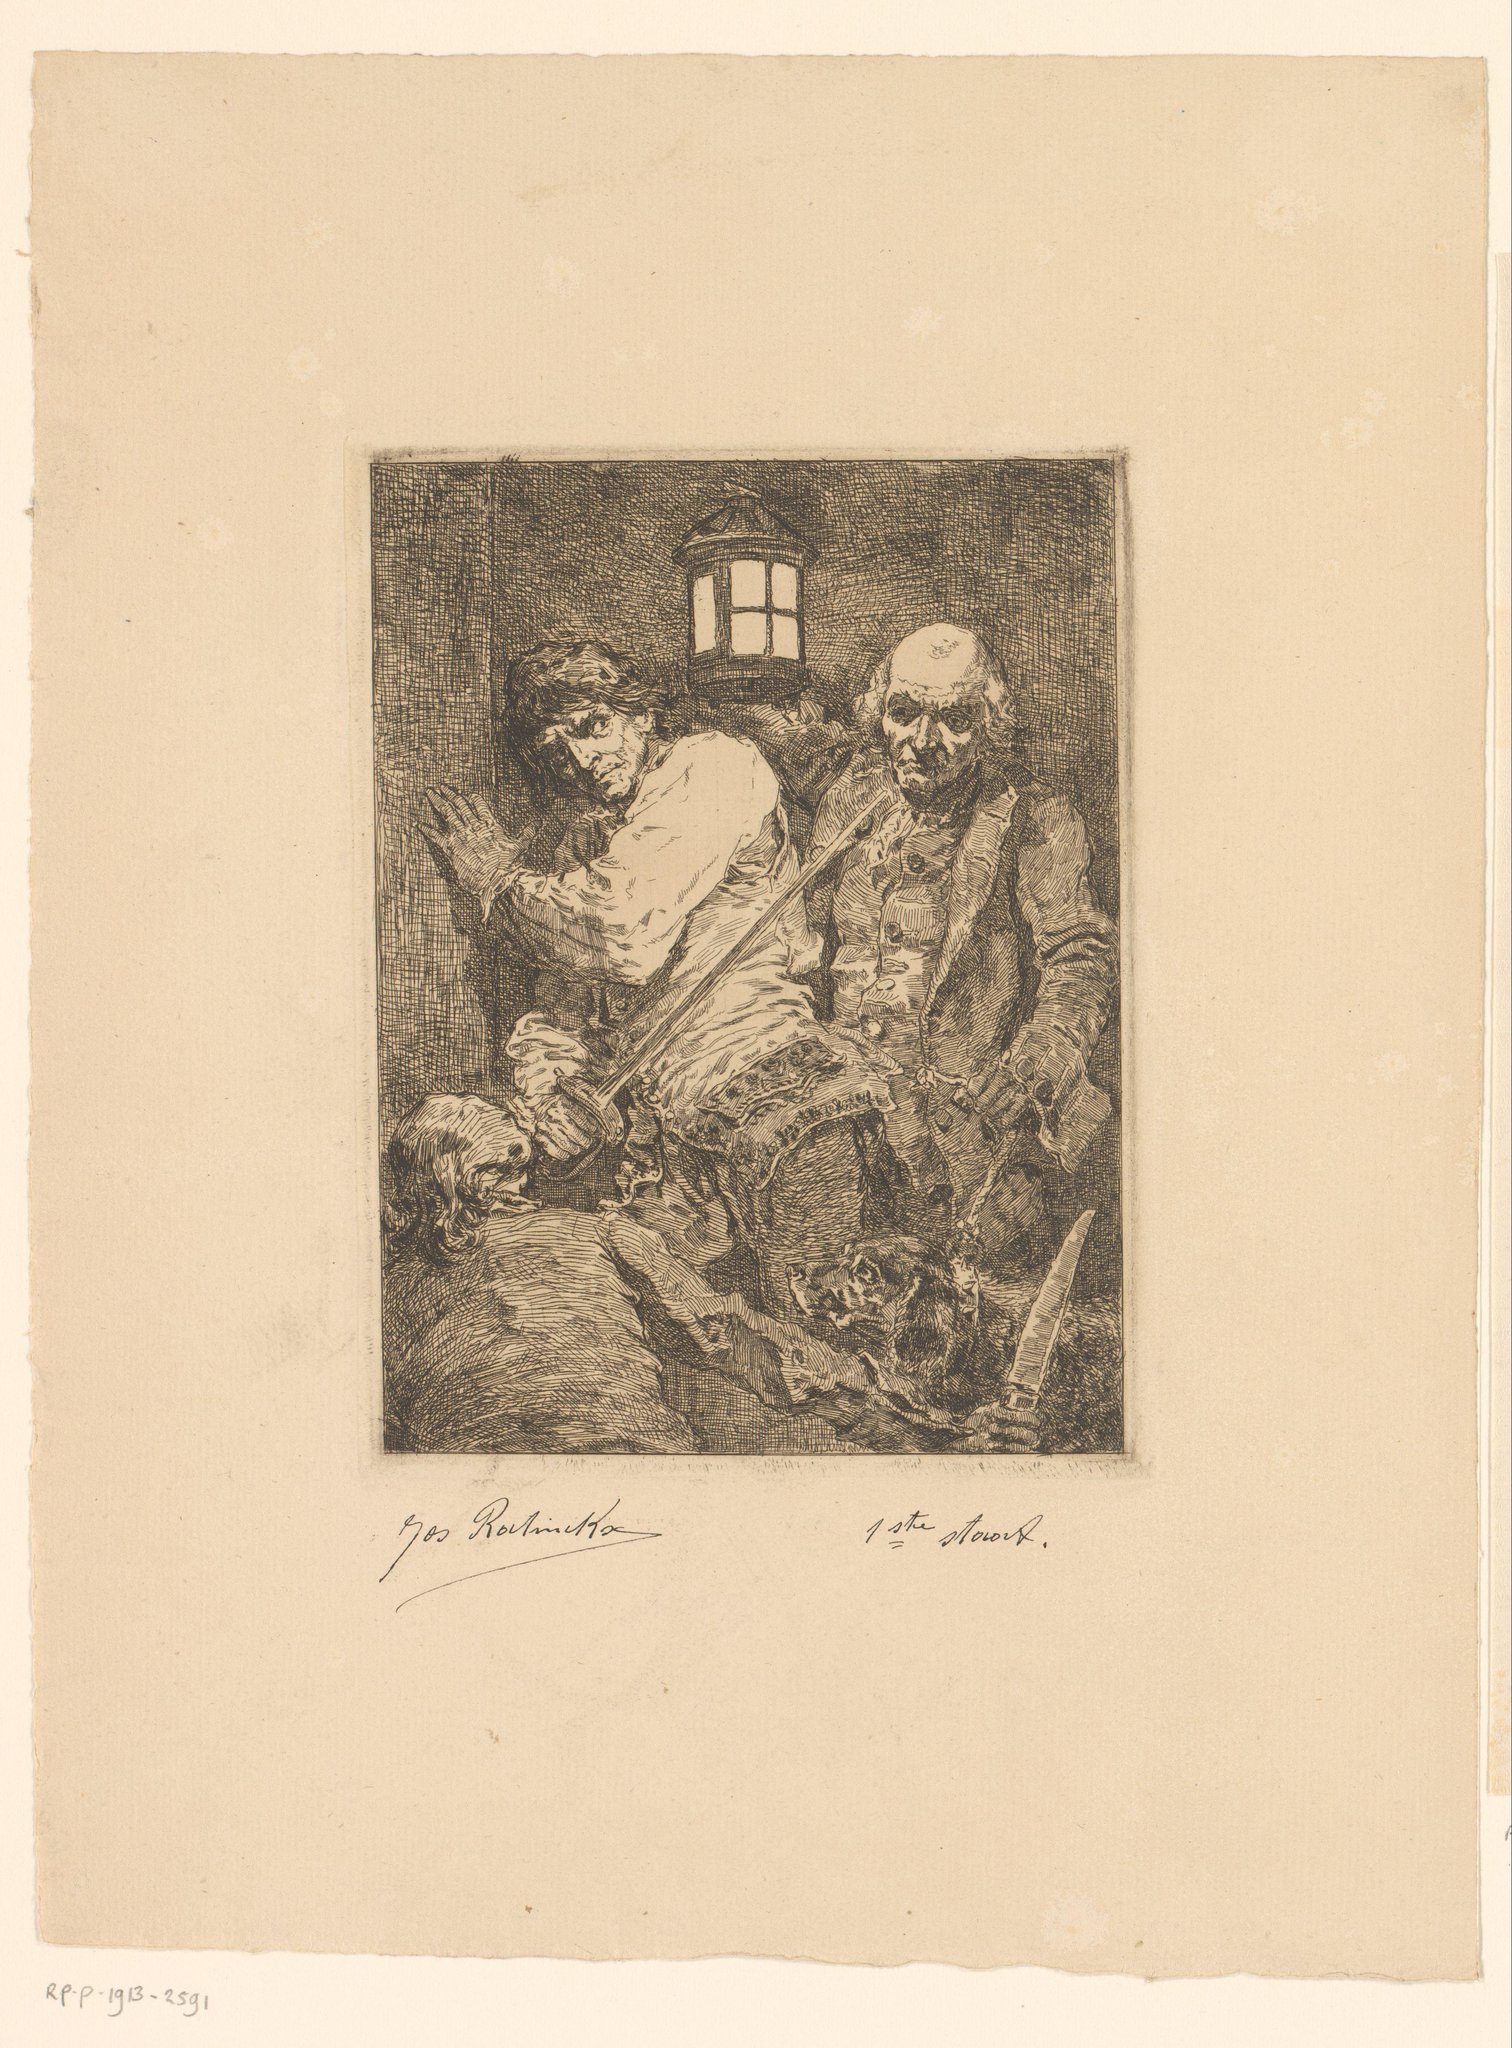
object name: print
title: Man verdedigt zichzelf met een zwaard tegenover een man met lantaarn en hond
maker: jos ratinckx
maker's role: print maker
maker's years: 1860-1937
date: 1870-1913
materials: paper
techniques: etching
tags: hacking and thrusting weapons: sword, lantern, being attacked; defence, dog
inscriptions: collector's mark: Lugt 2228, inscription: ‘1ste staat’